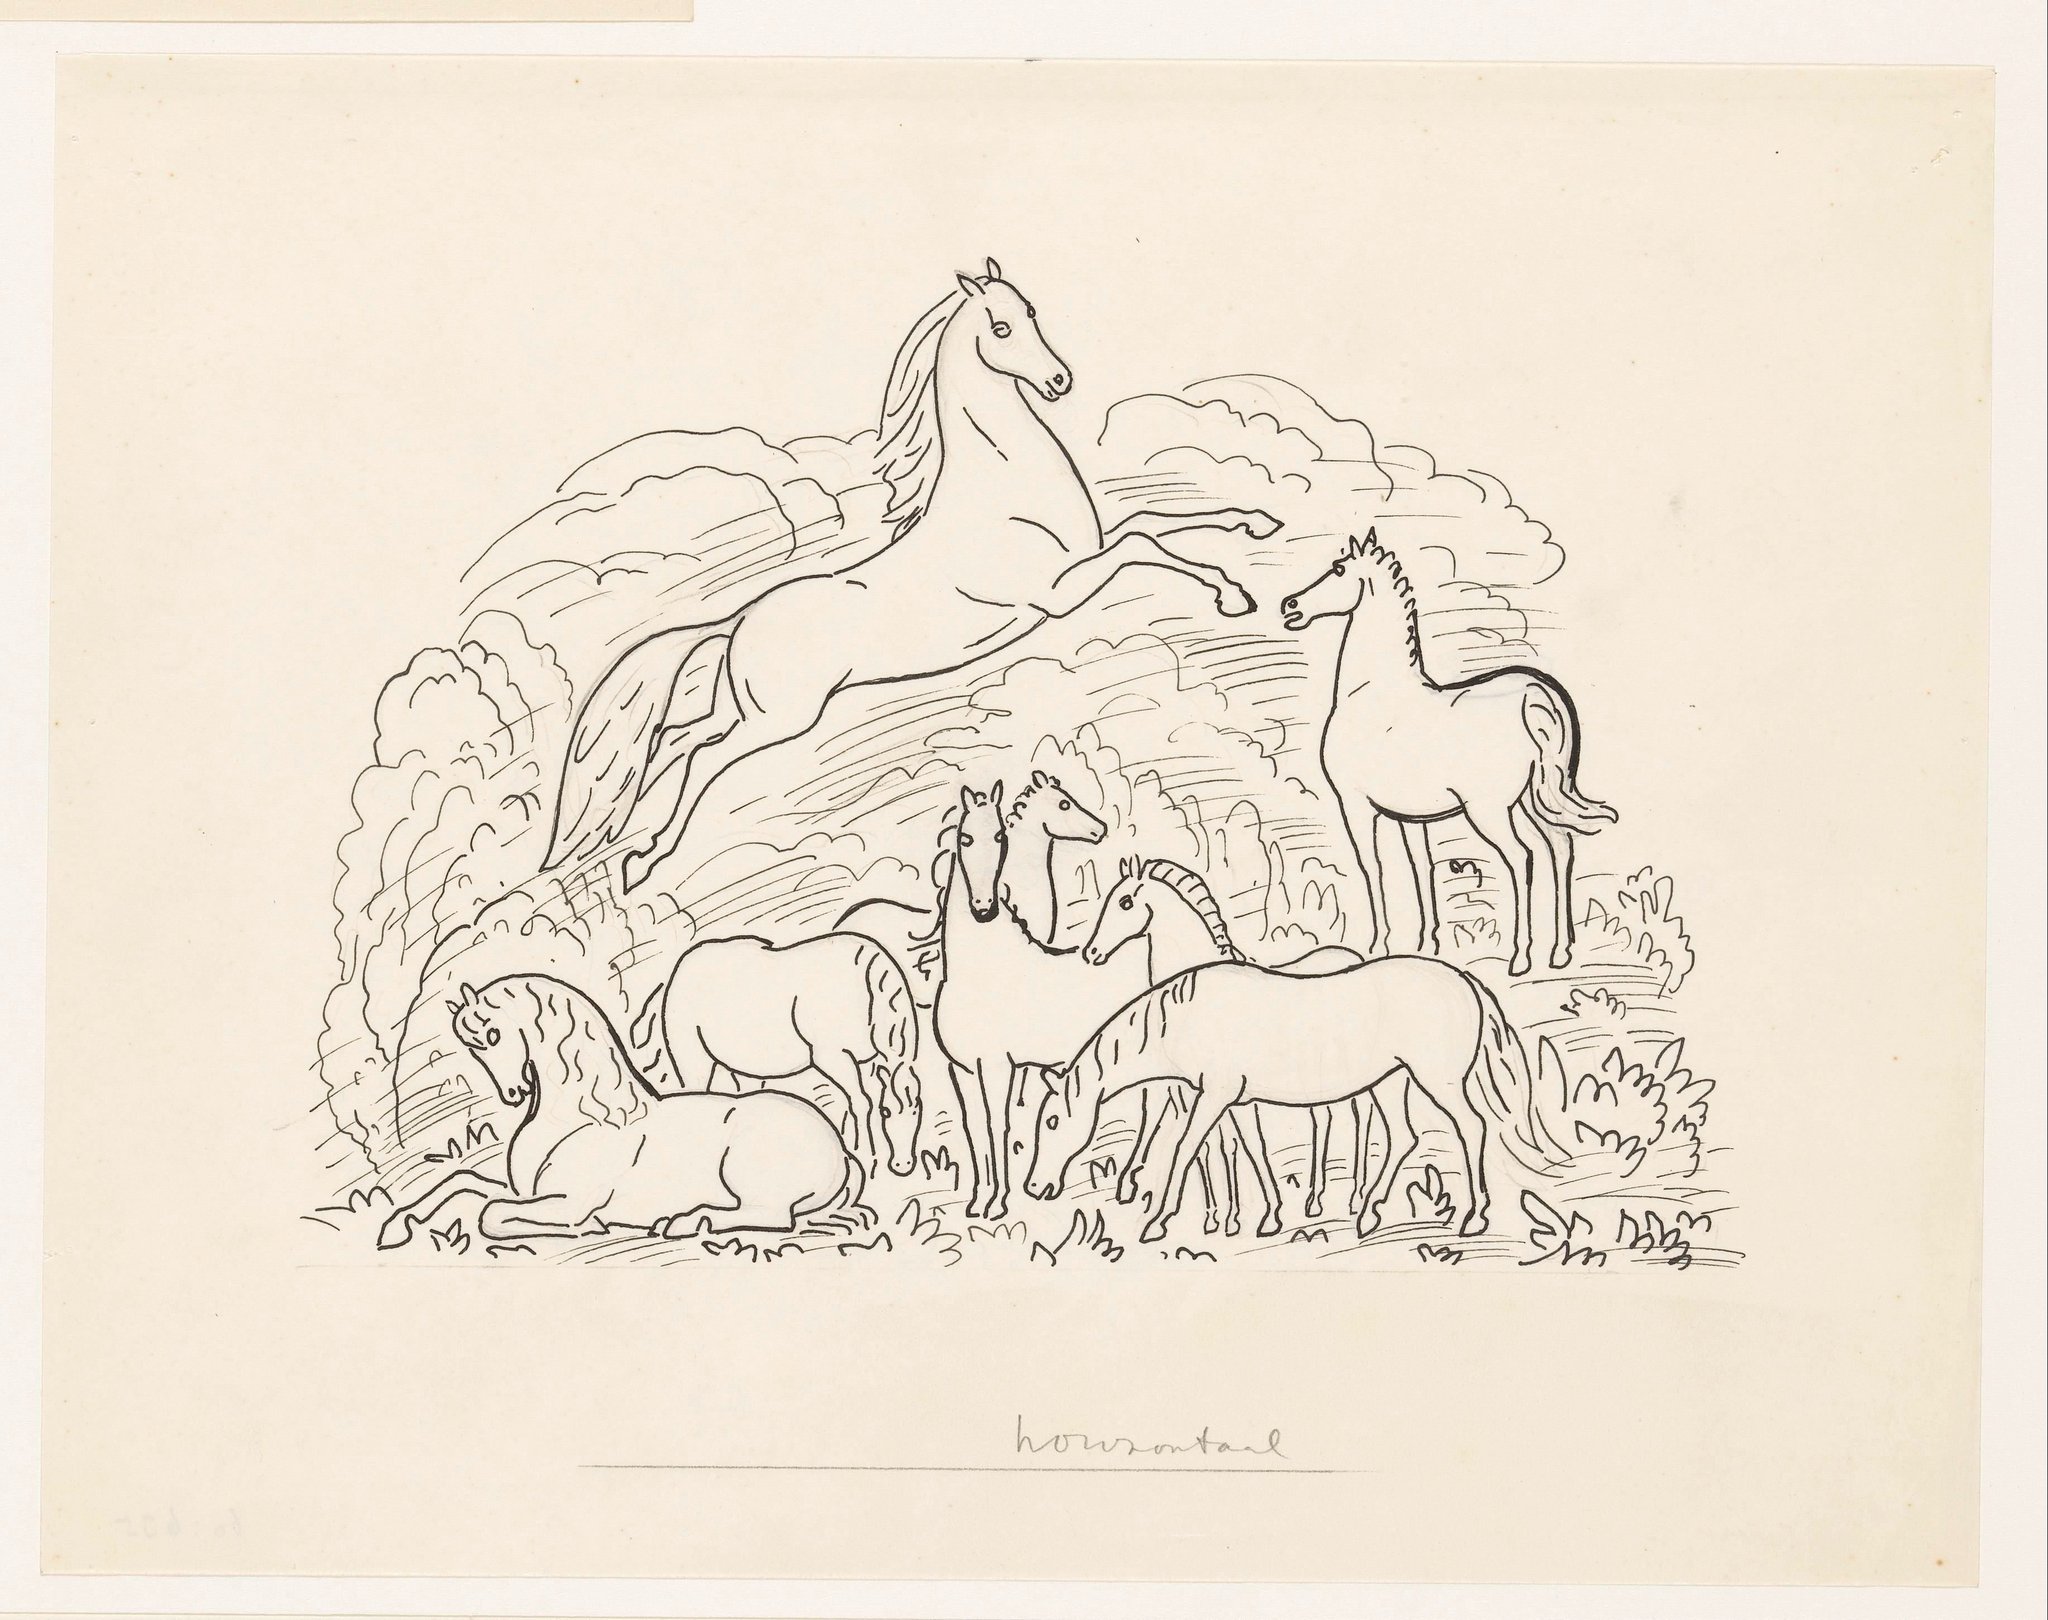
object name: drawing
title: Studieblad met acht paarden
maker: leo gestel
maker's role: draughtsman, print maker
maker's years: 1881-1941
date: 1891-1941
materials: ink, paper, pencil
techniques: pen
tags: horse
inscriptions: watermark: ‘GW/ PAPIER/ 1671’